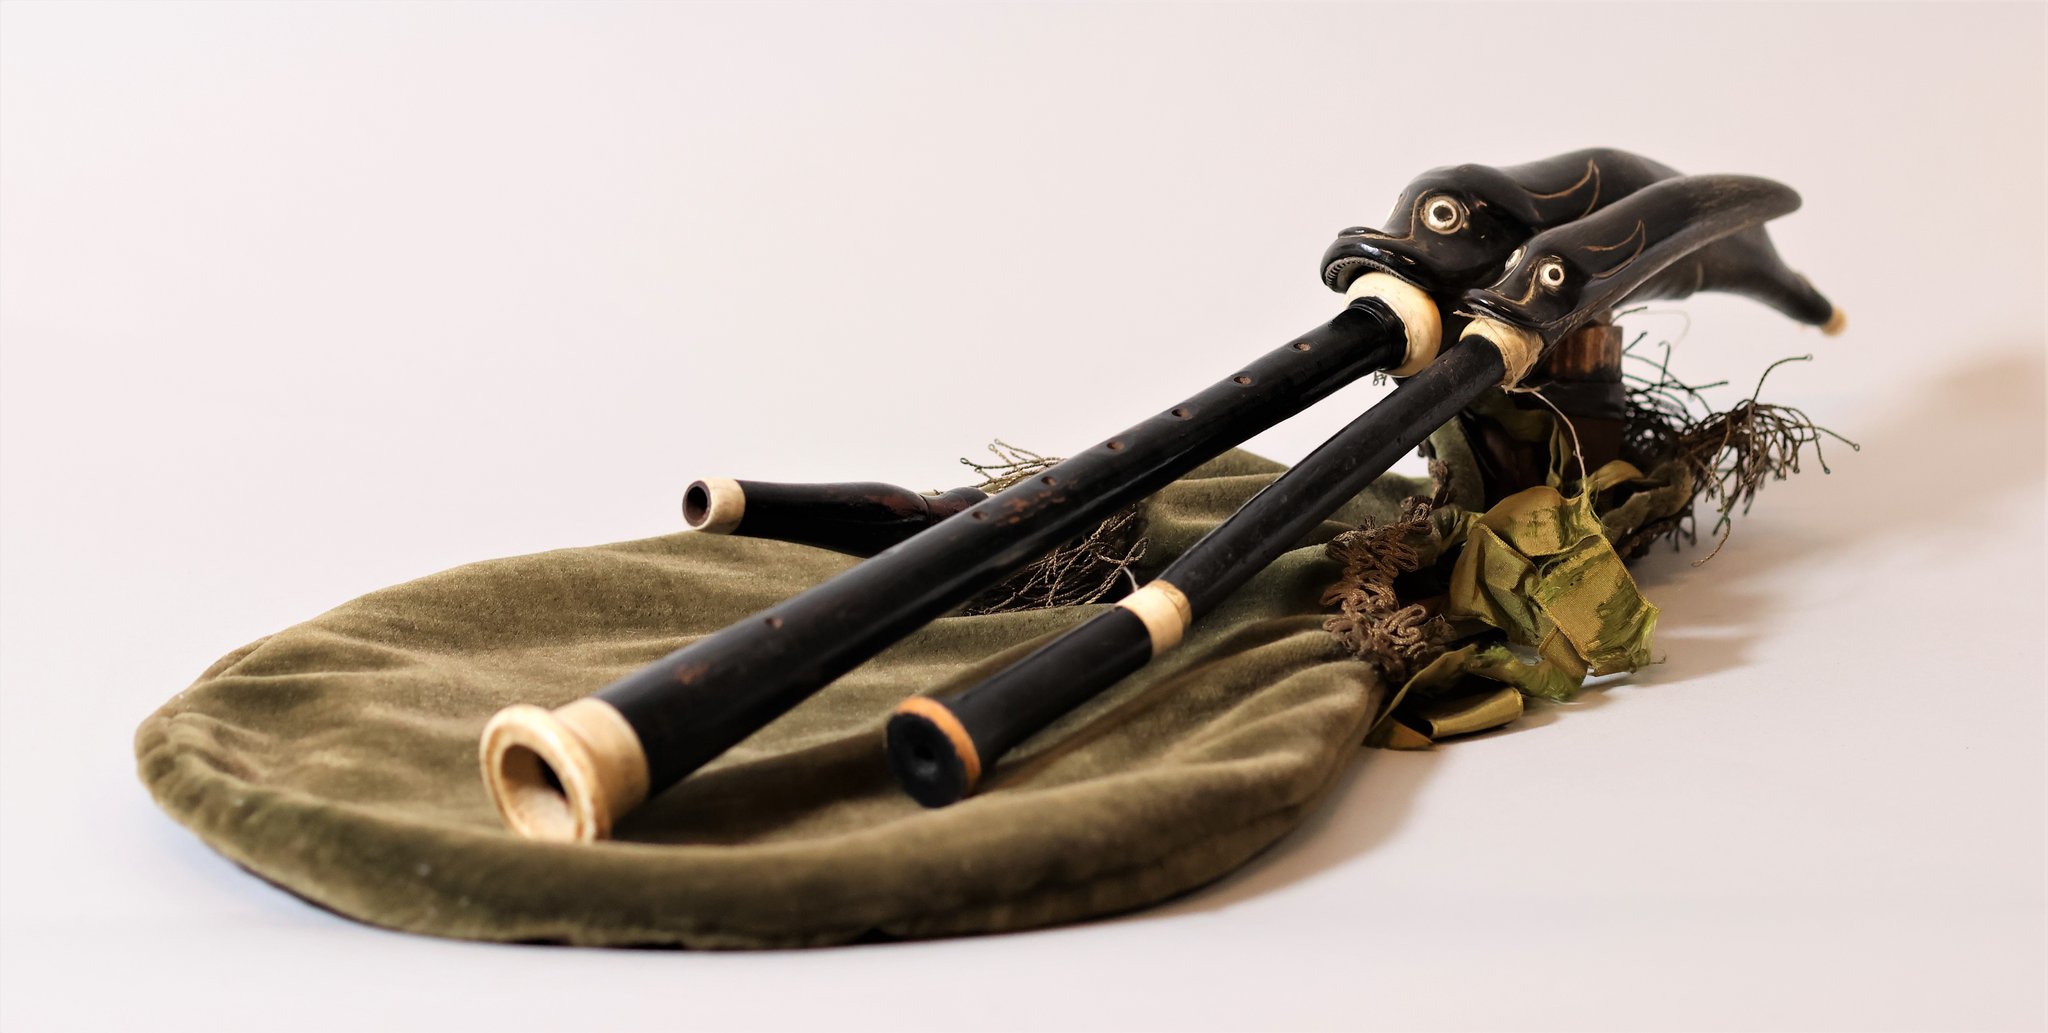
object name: gaillard musette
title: ‘Gaillard’ Musette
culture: french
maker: p. gaillard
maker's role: maker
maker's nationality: french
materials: horn, ivory, leather, wood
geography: france